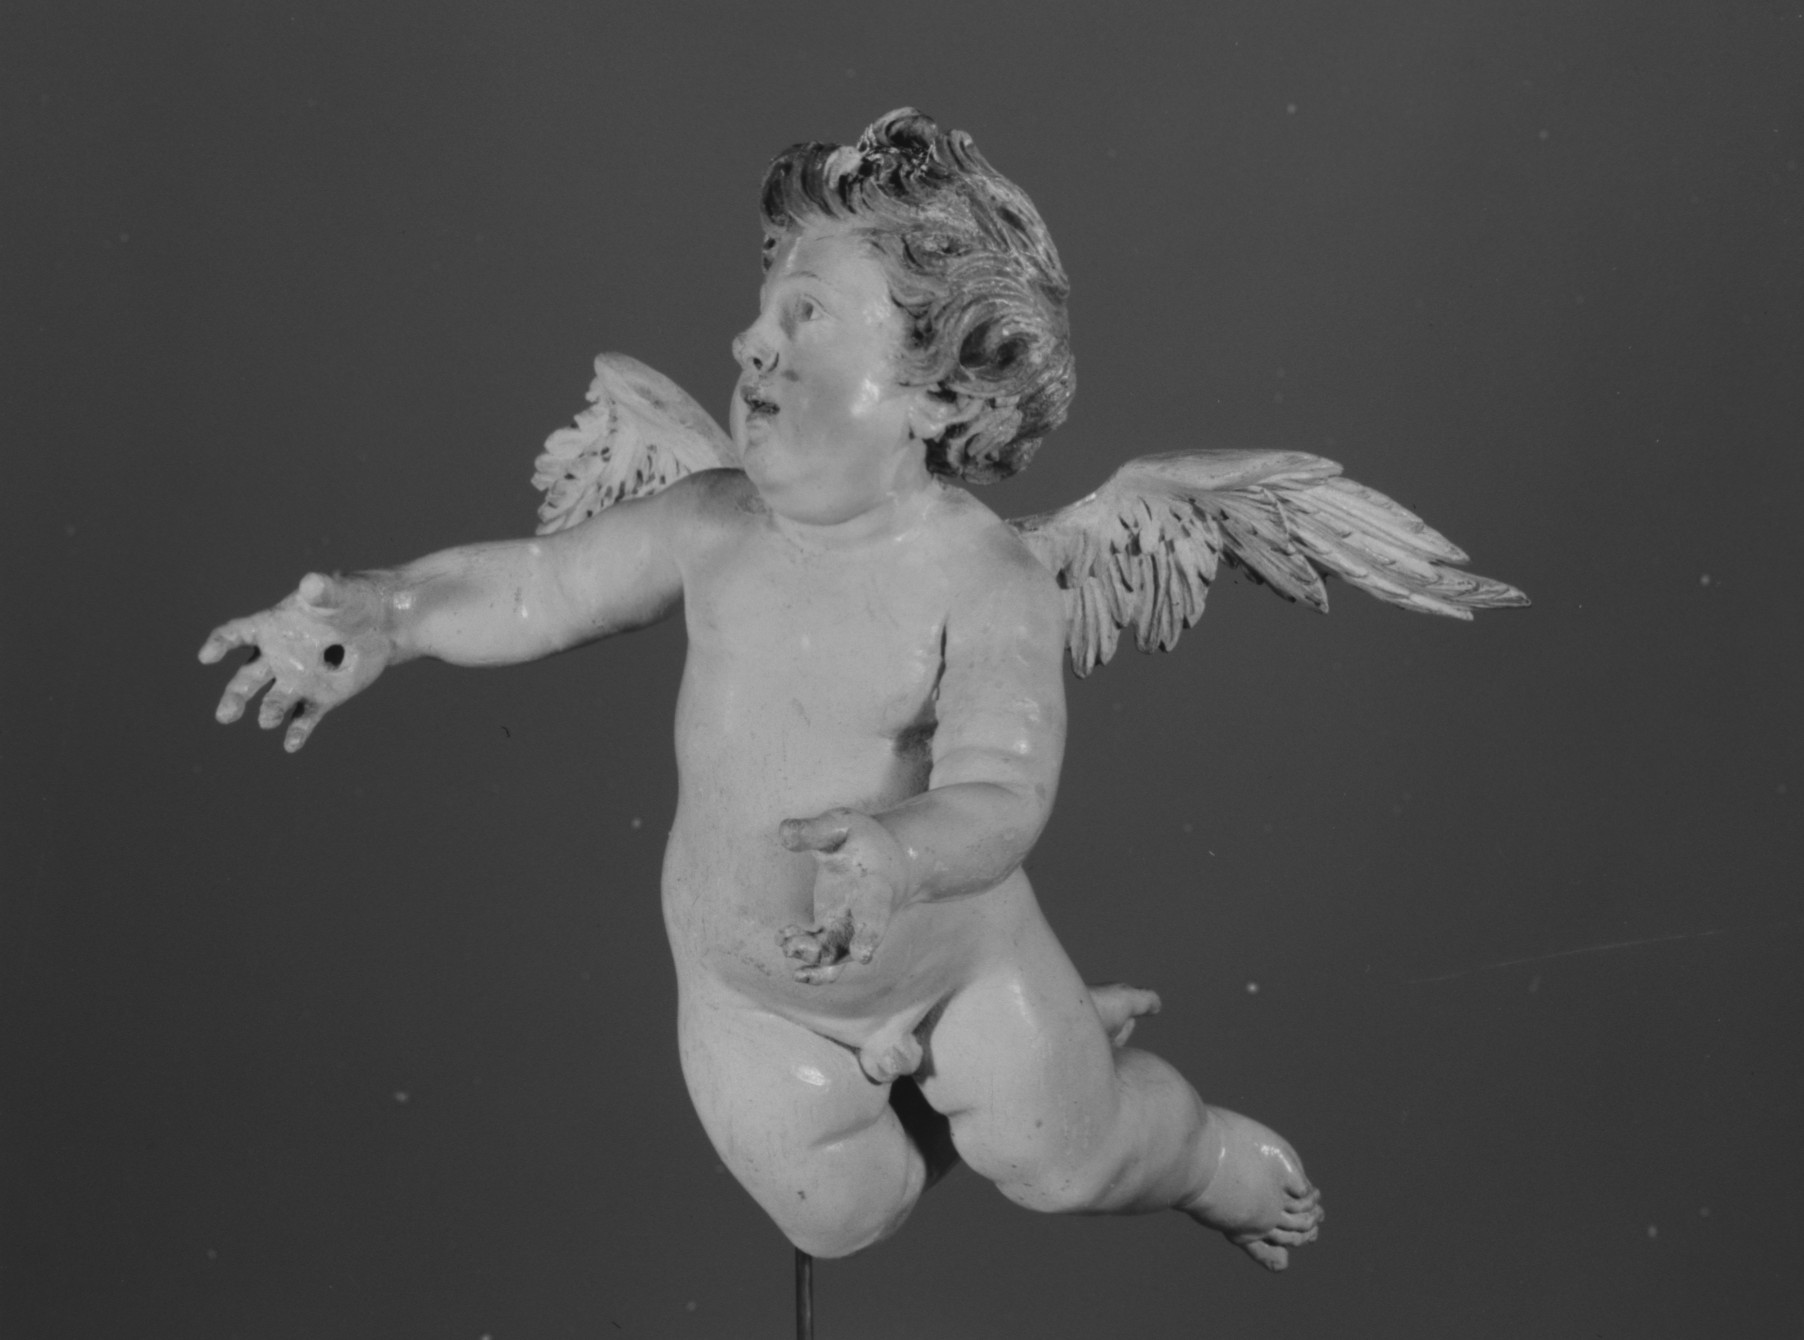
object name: crèche figure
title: Cherub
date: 1751-1800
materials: wood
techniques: polychrome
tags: angels